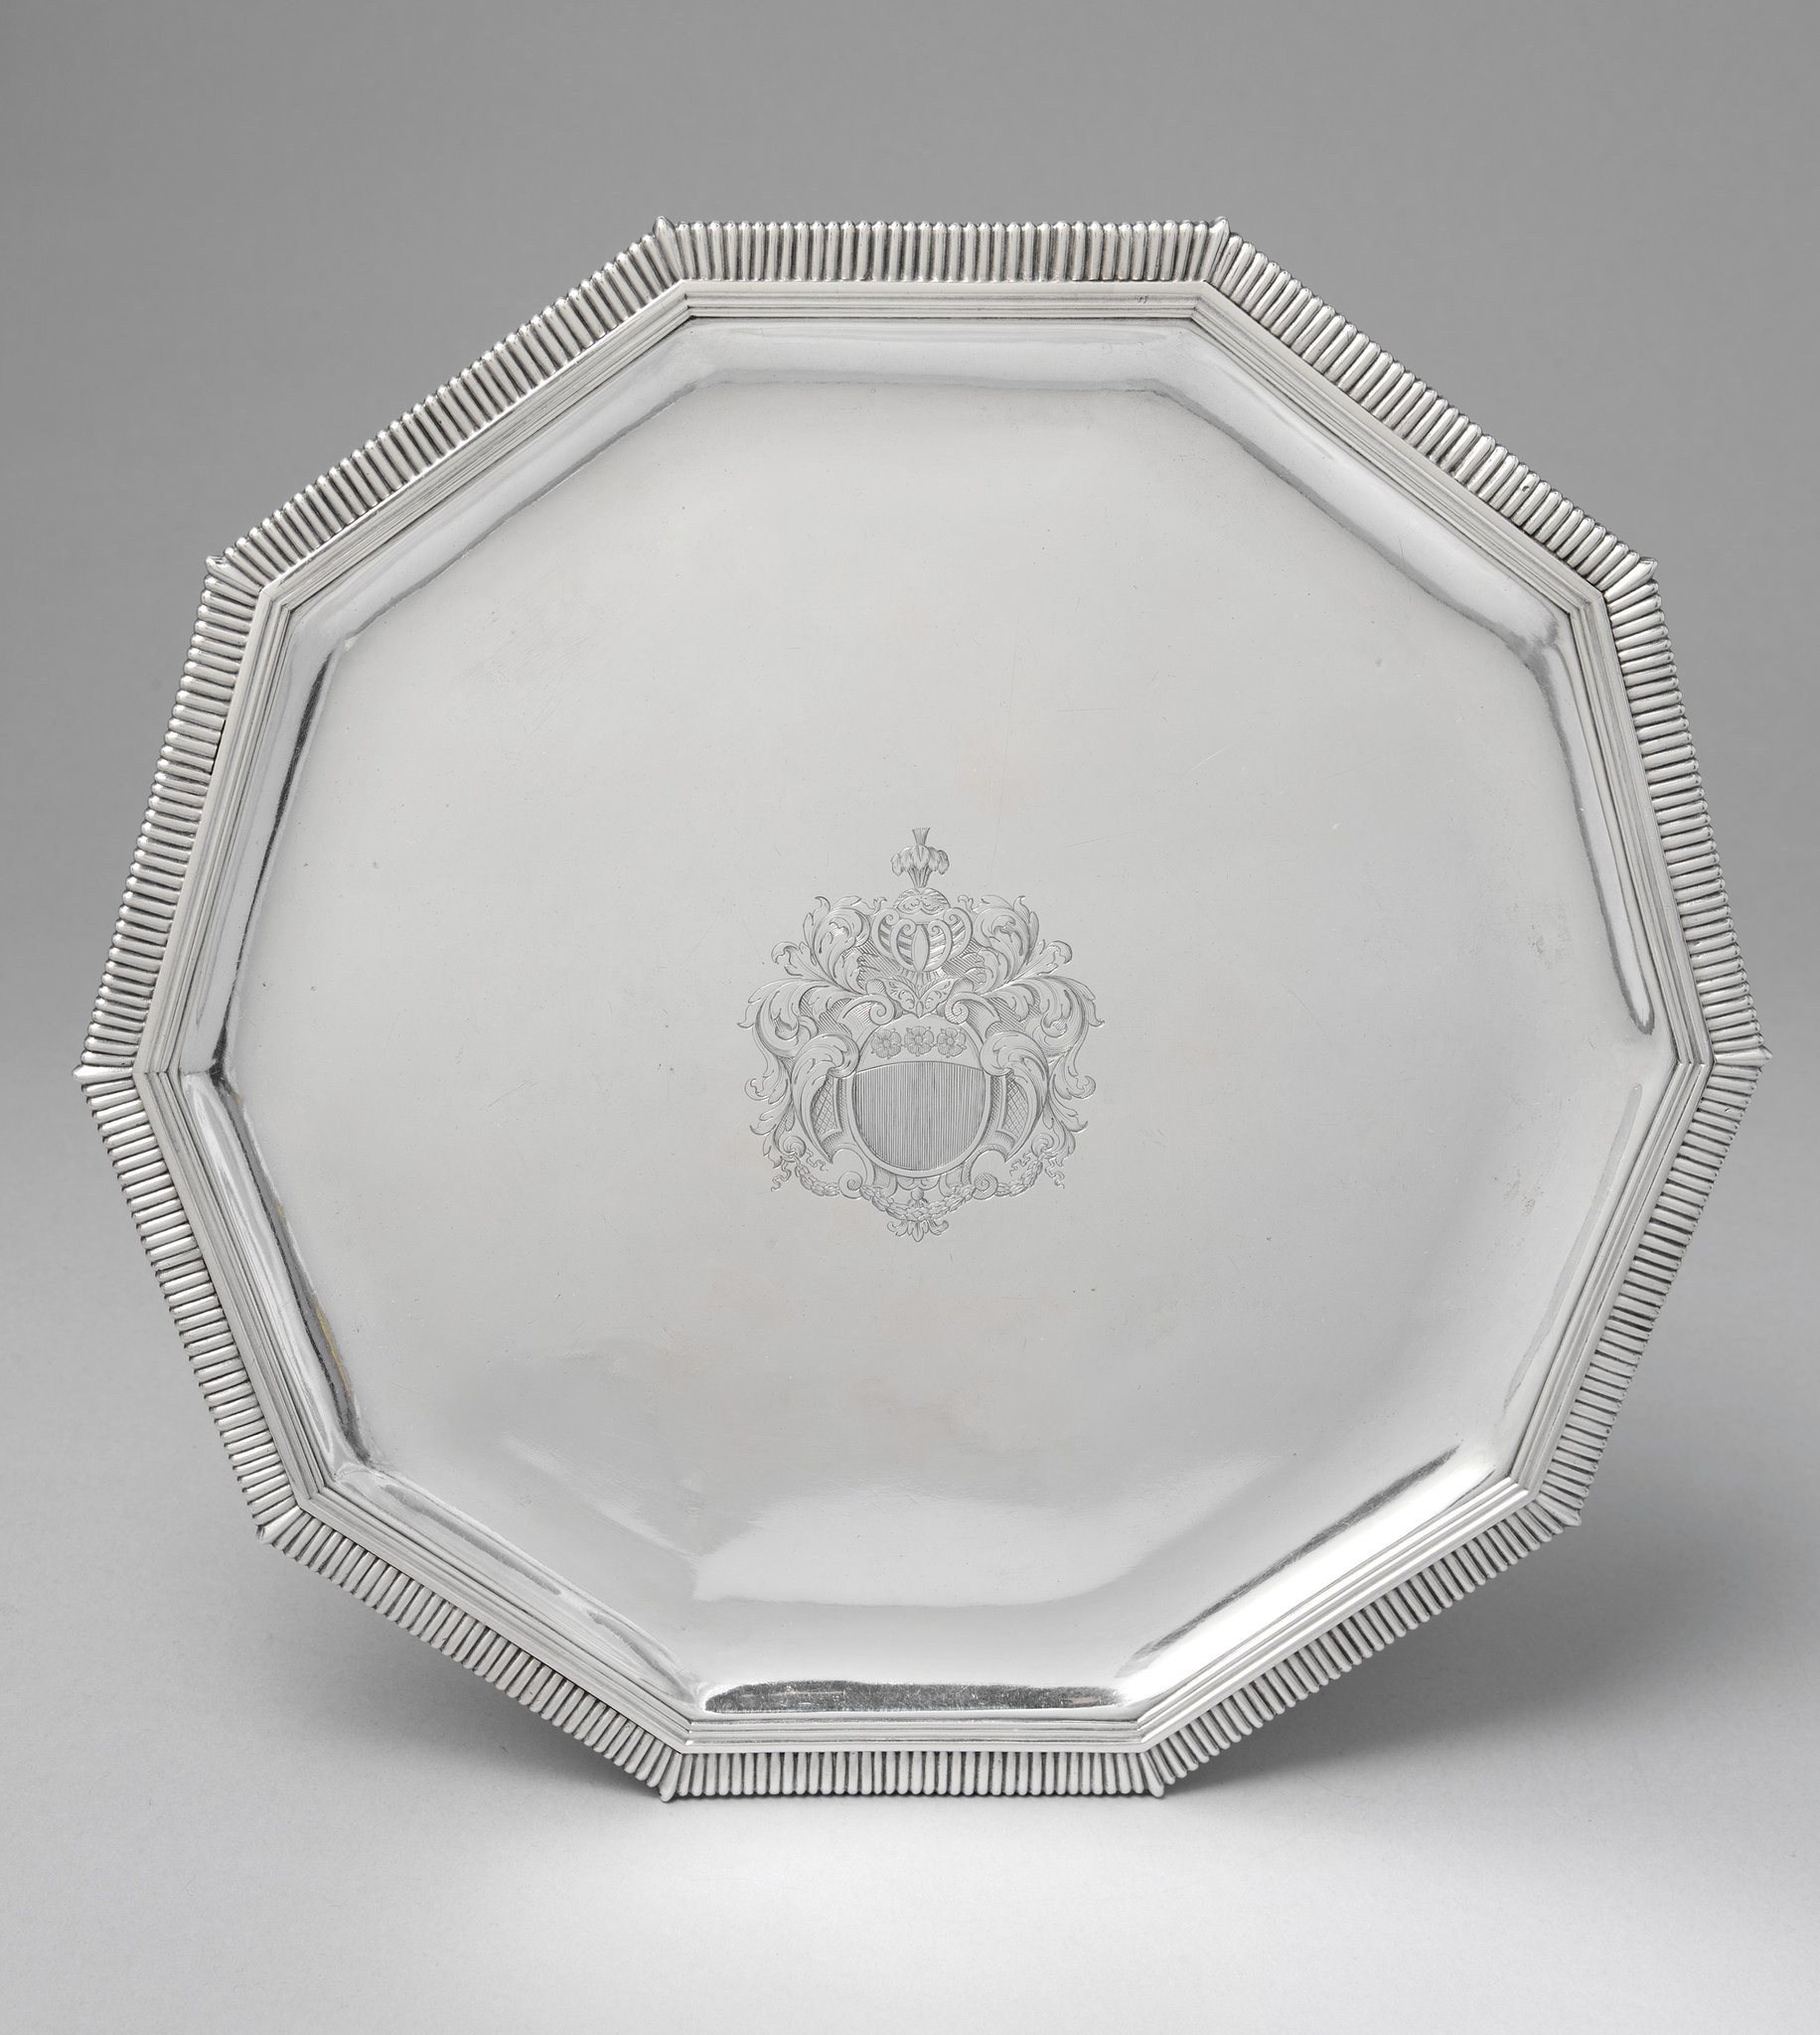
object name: salver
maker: jean-joseph giraud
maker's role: maker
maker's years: 1677-1781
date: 1729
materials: silver